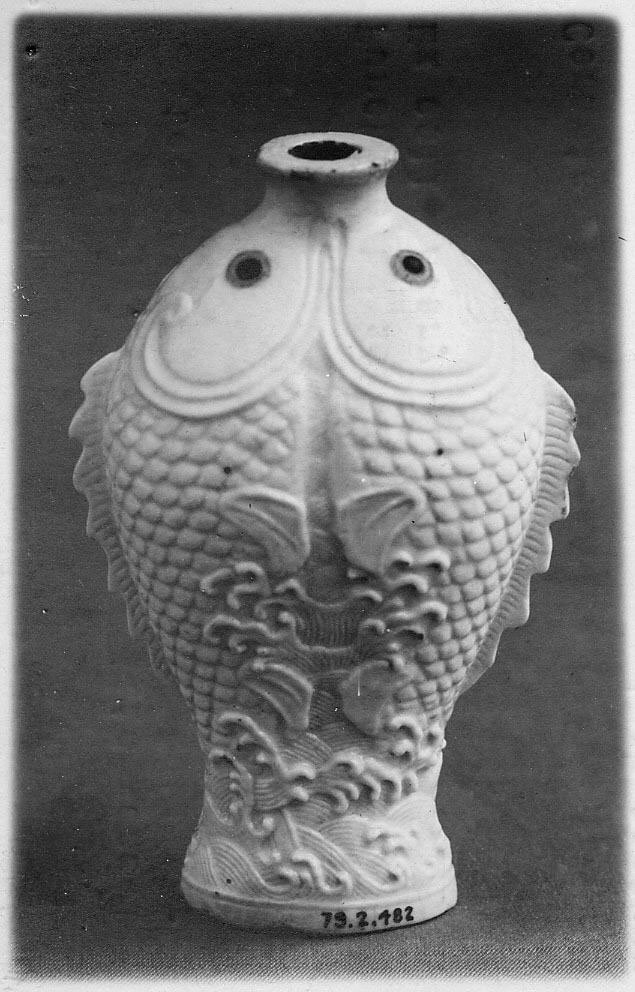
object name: snuff bottle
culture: chinese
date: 1701-1800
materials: porcelain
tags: fish